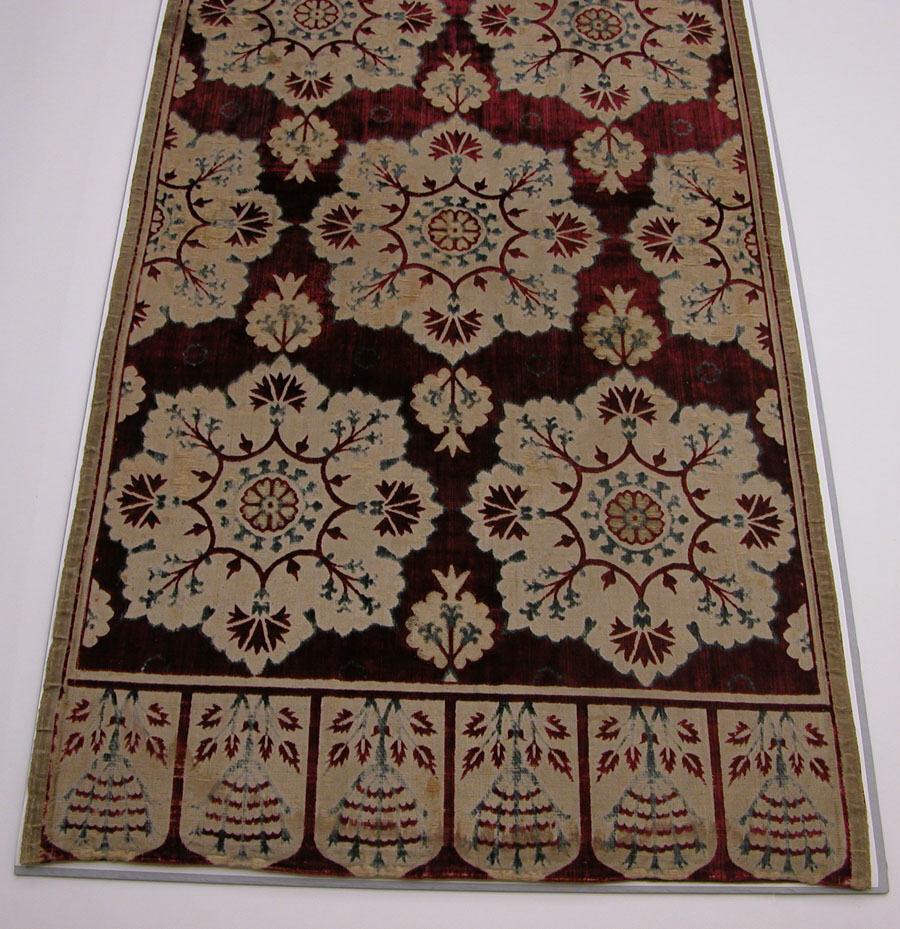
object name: cushion cover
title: Cushion Cover (Yastik)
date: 1601-1700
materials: linen, silk, velvet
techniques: brocade, cutting, voiding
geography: turkey